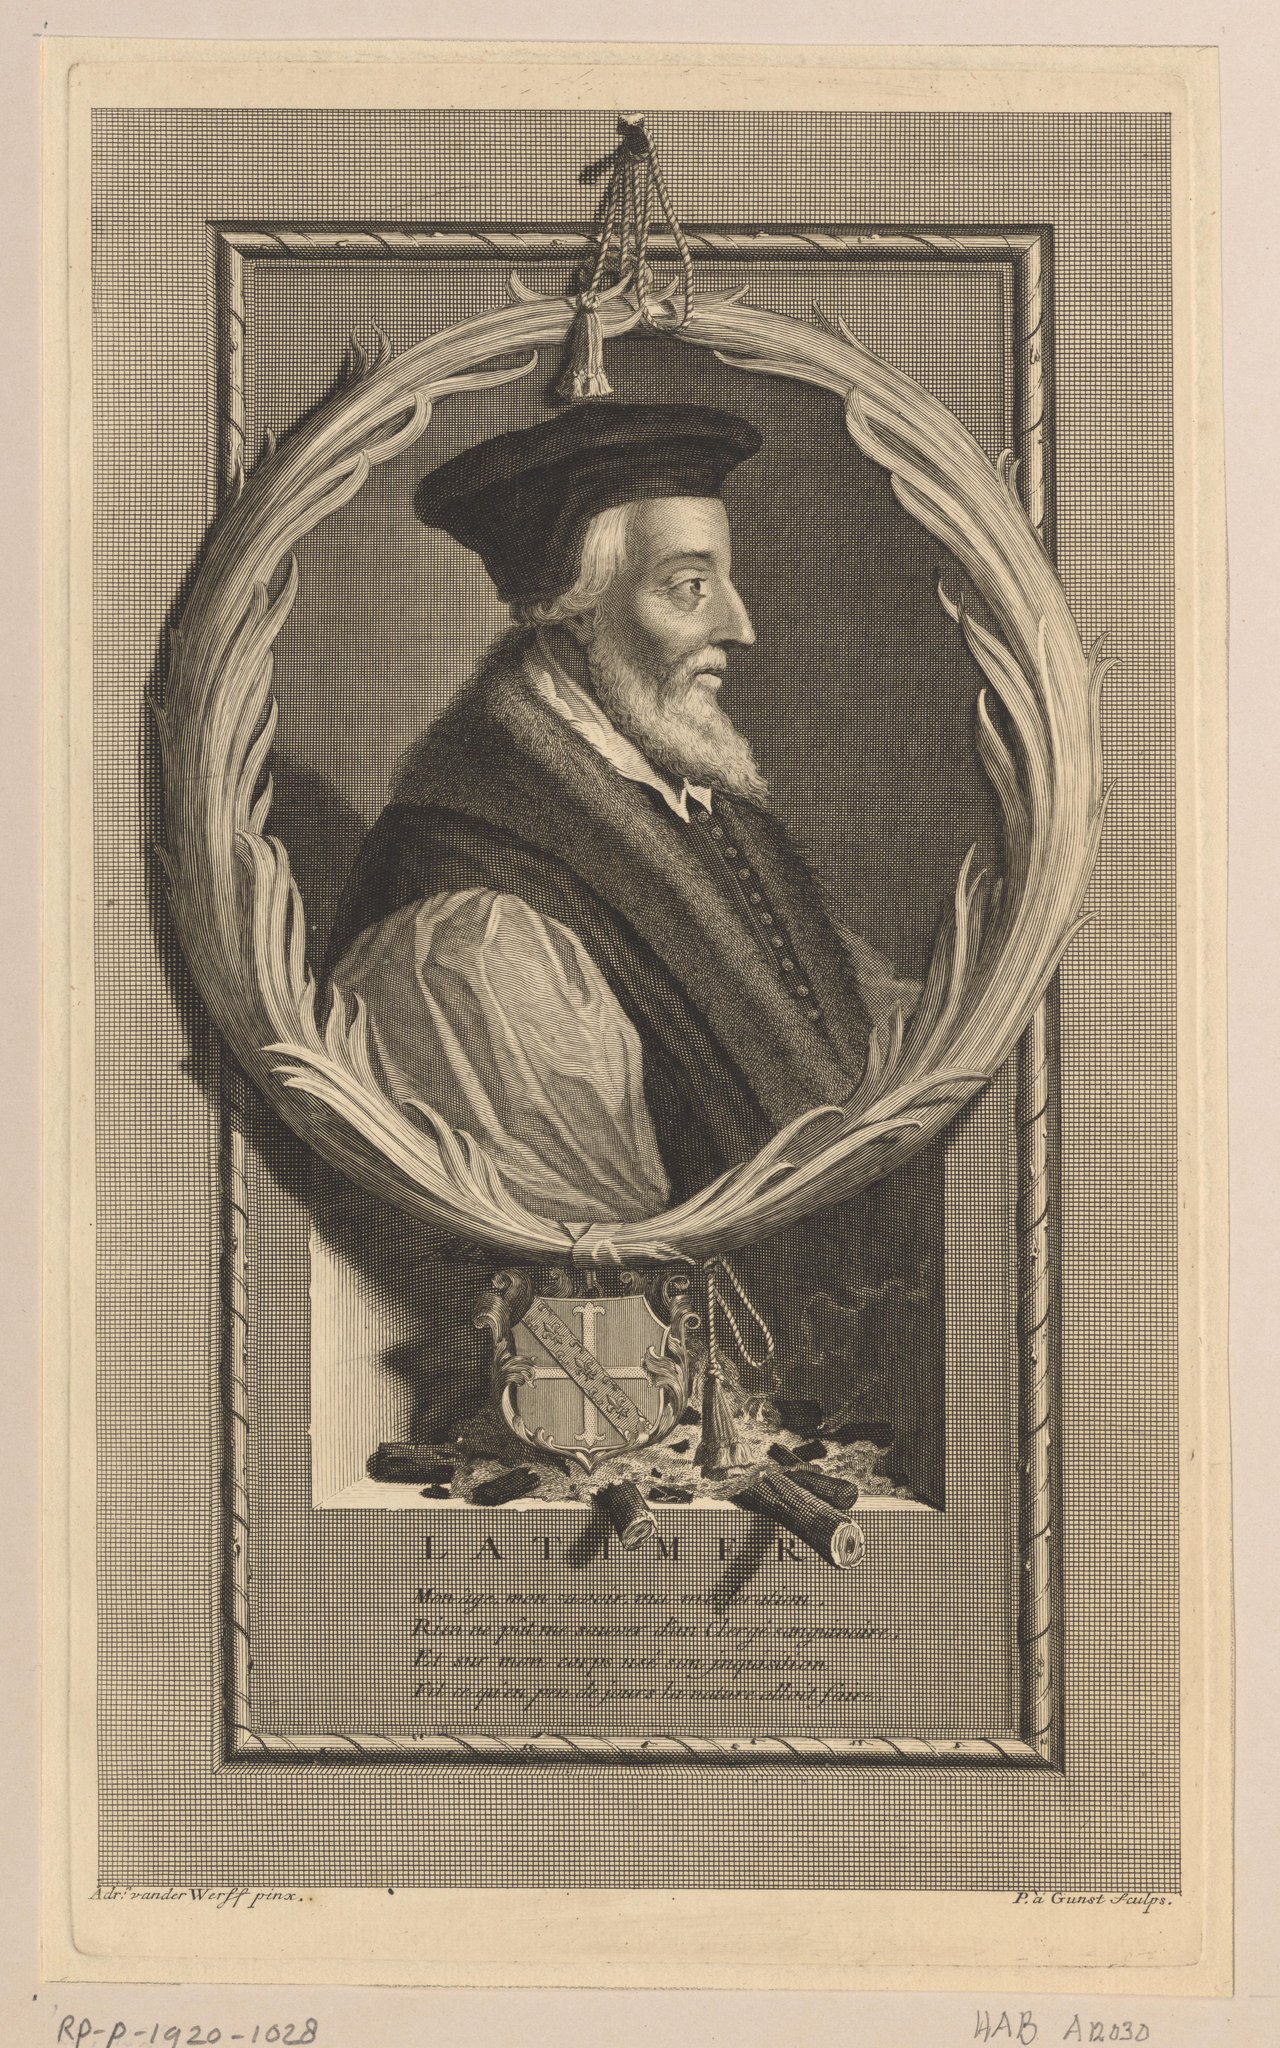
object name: print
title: Portret van Hugh Latimer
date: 1697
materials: paper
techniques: engraving, etching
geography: amsterdam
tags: ornament ~ medallion, historical persons, violent death by burning at the stake; pyre, armorial bearing, heraldry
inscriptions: collector's mark: Lugt 2228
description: Prent waarschijnlijk uit: Larrey, Isaac de. Histoire d’Angleterre, d’Écosse, et d’Irlande (...). Rotterdam: Reinier Leers, 1697.